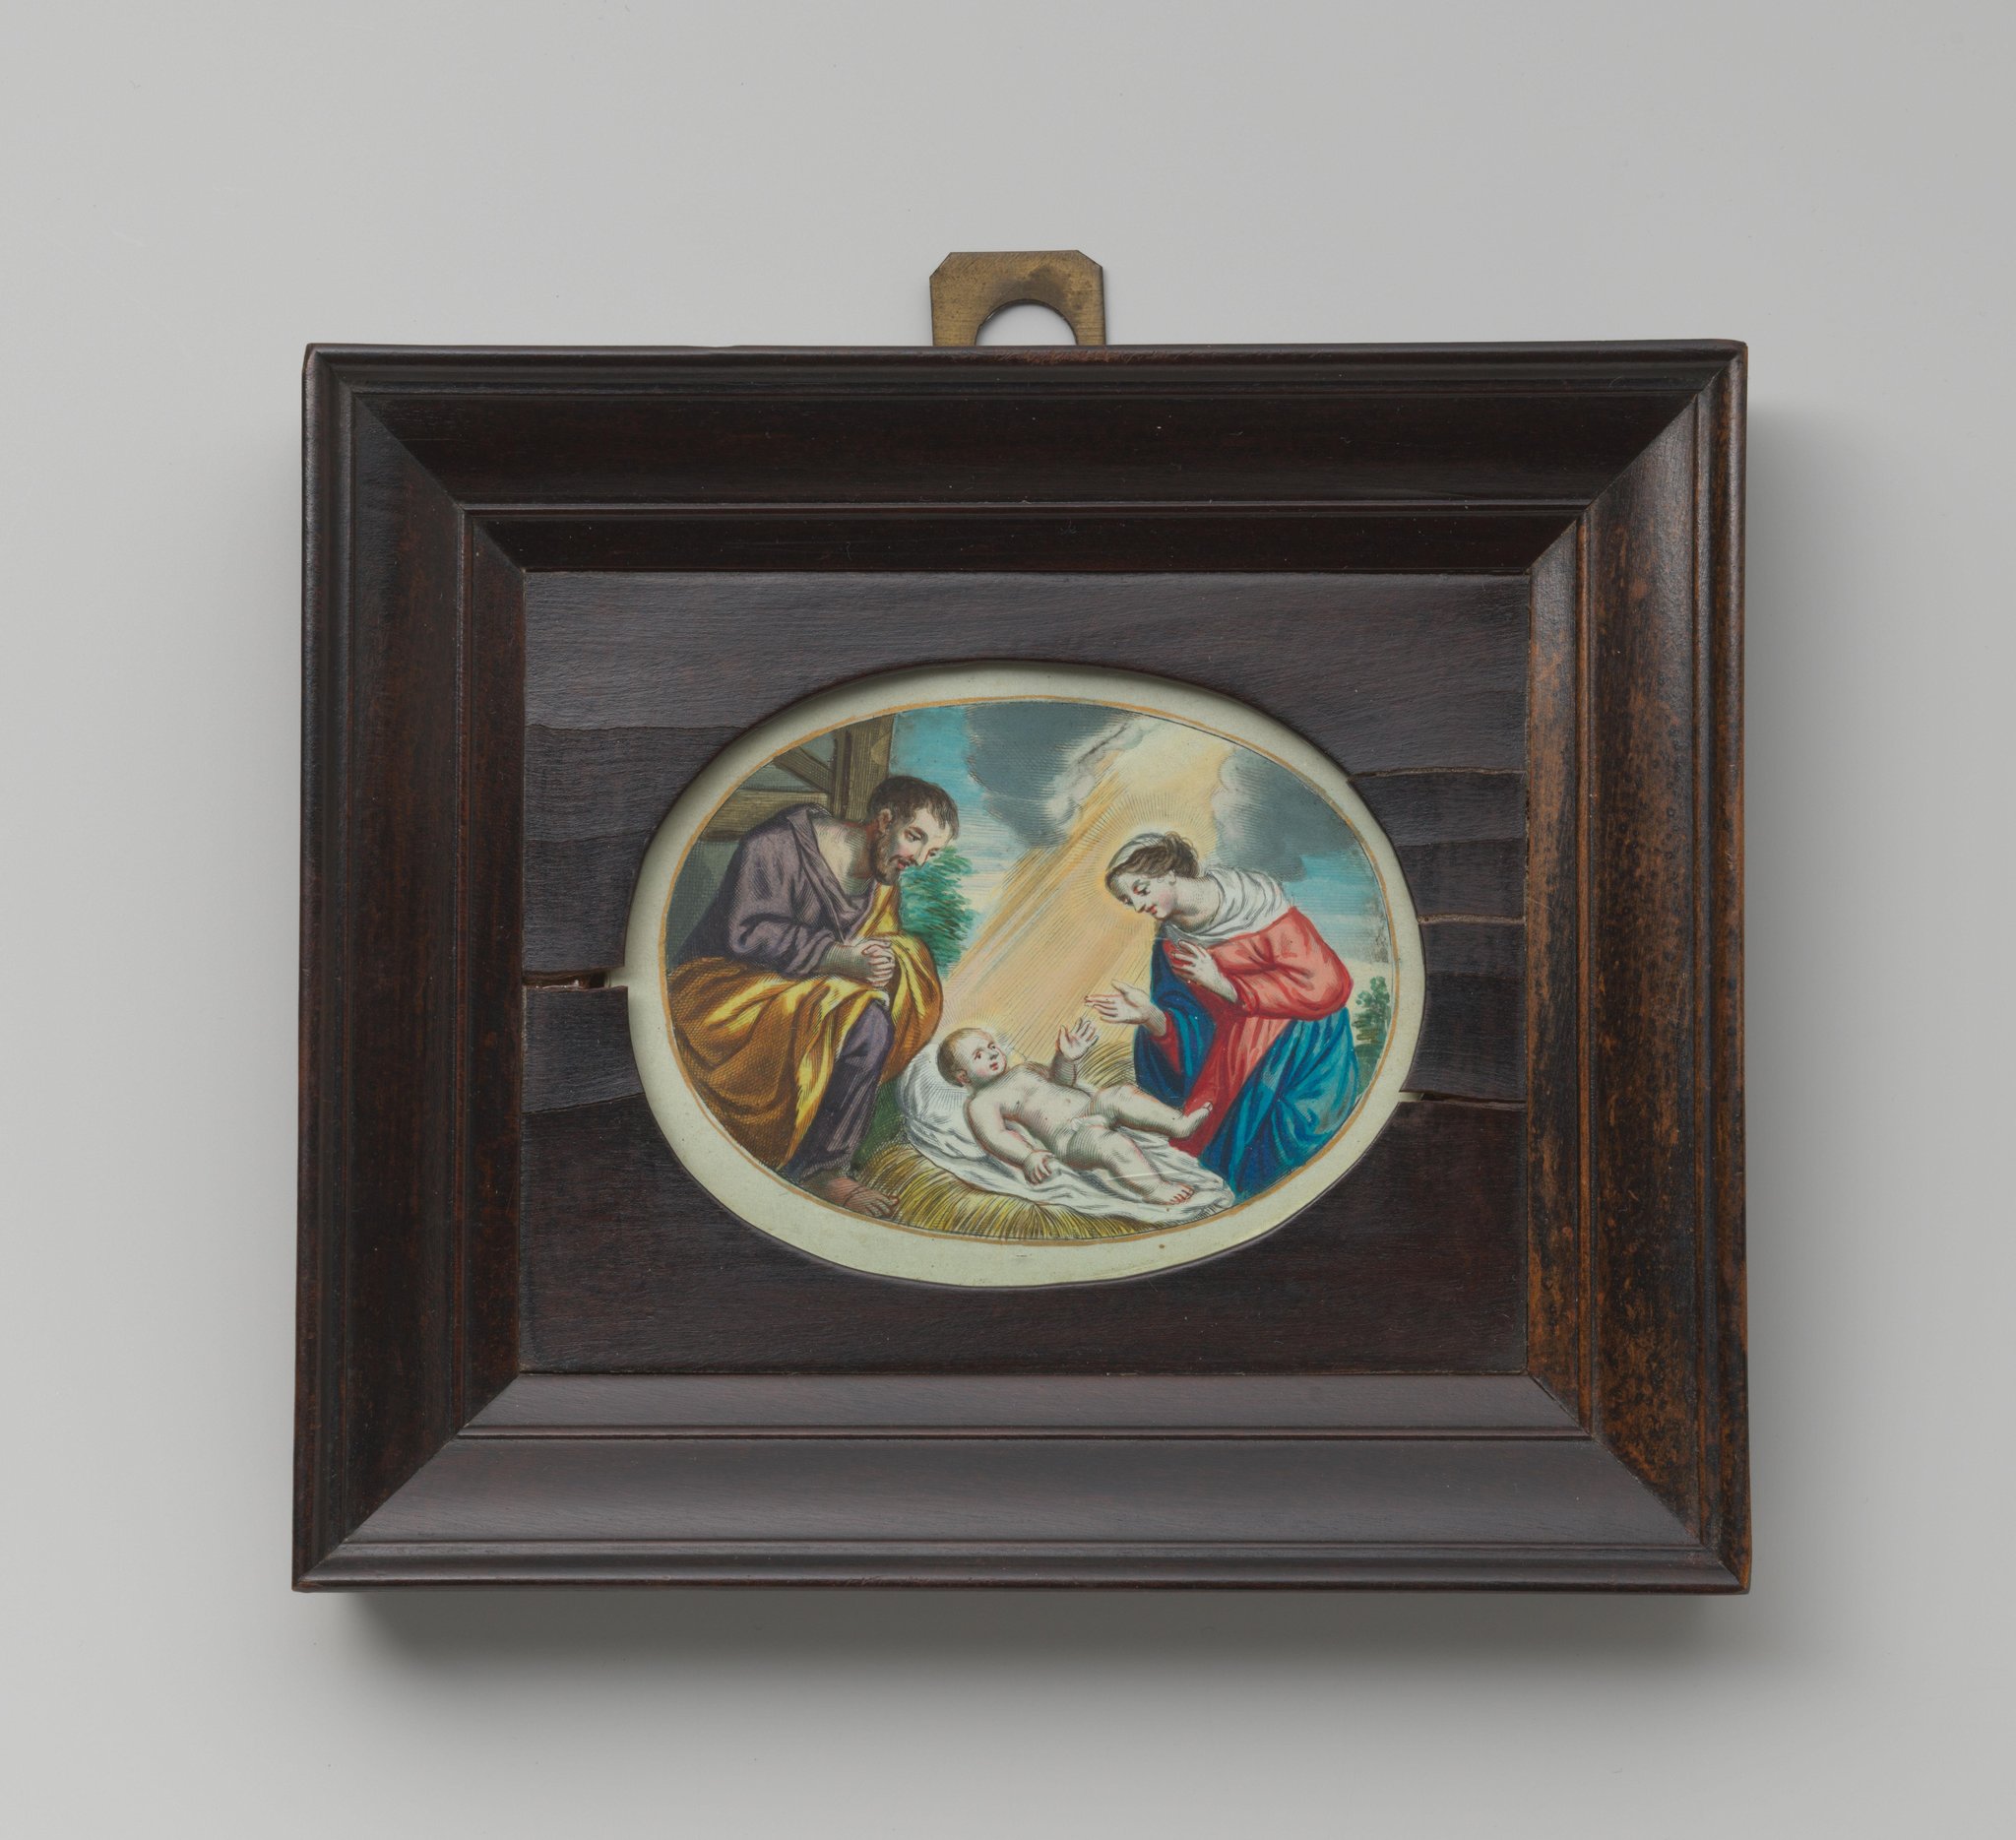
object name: print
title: Prent met de aanbidding door Maria en Jozef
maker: Anonymous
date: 1650-1700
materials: paint, glass, gouache, wood, parchment, ink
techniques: etching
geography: antwerp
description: Prent met de aanbidding door Maria en Jozef, ovale ets op perkament, ingekleurd met gouache en goudverf. Gevat achter glas in een lijst van eikenhout, belijmd met zwartgekleurd perenhout. Aan de lijst een koperen plaatje met gat ter bevestiging.